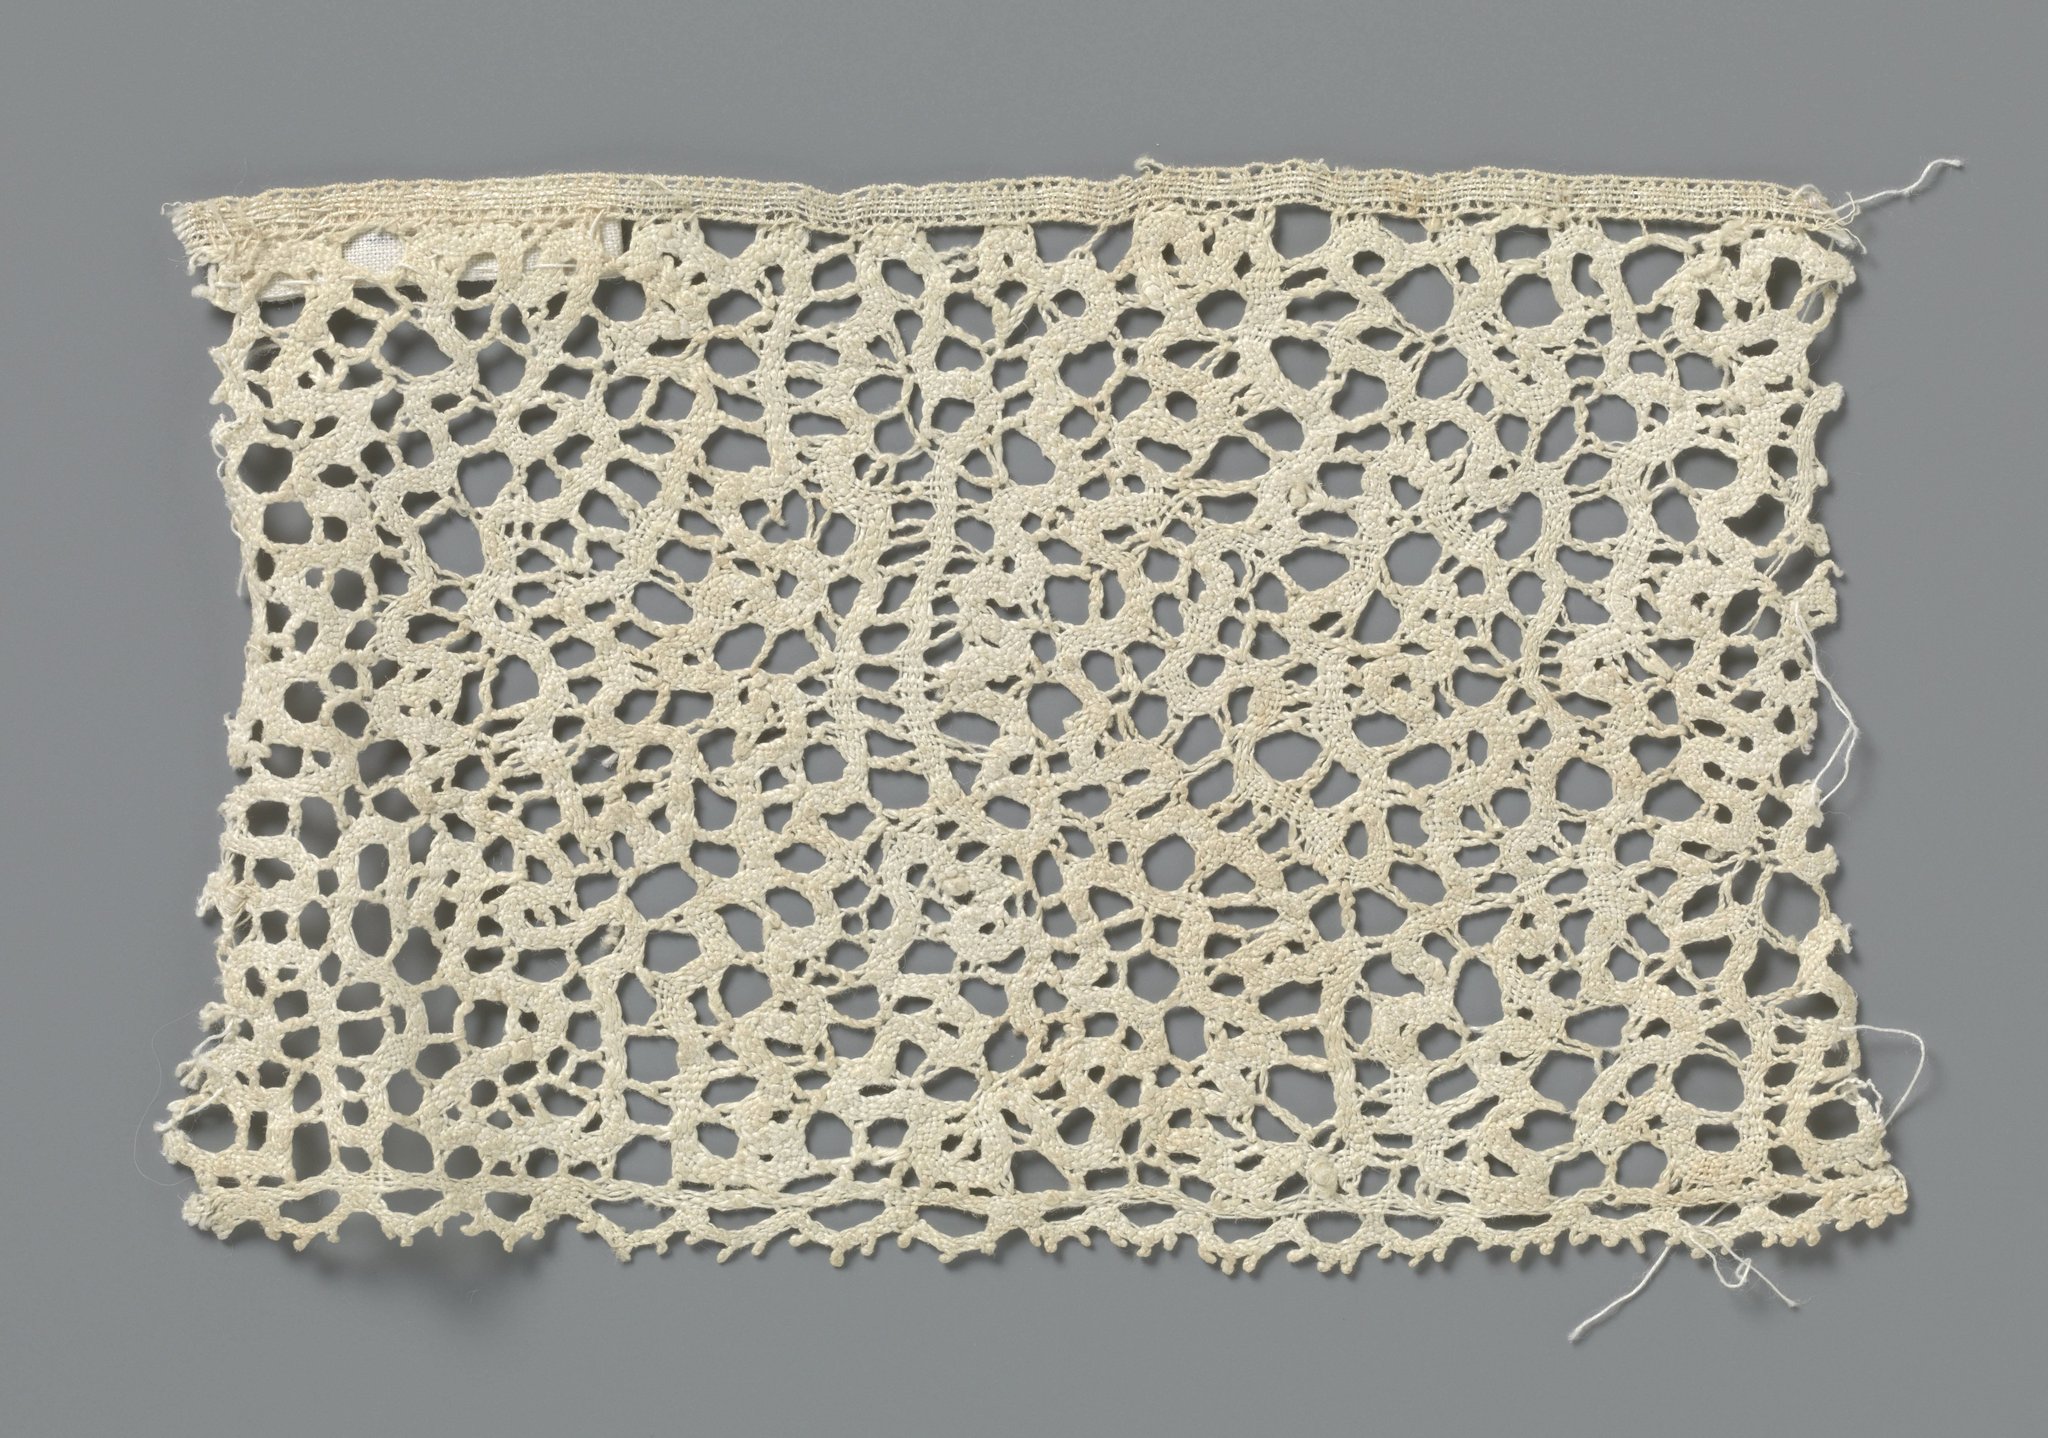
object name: strip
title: Strook kloskant met warrig lintenpatroon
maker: Anonymous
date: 1890-1899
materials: linen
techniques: lace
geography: milan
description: Strook naturelkleurige kloskant. Het warrige patroon wordt gevormd door een sterk kronkelend lint, gemaakt in dichtgewerkte linnenslag. Tussen de kronkels in zijn verbindingen gemaakt met vlechtjes. De bovenzijde is afgewerkt met een apart geklost bandje. Langs de rechte onderzijde loopt een rand van gepicoteerde boogjes.